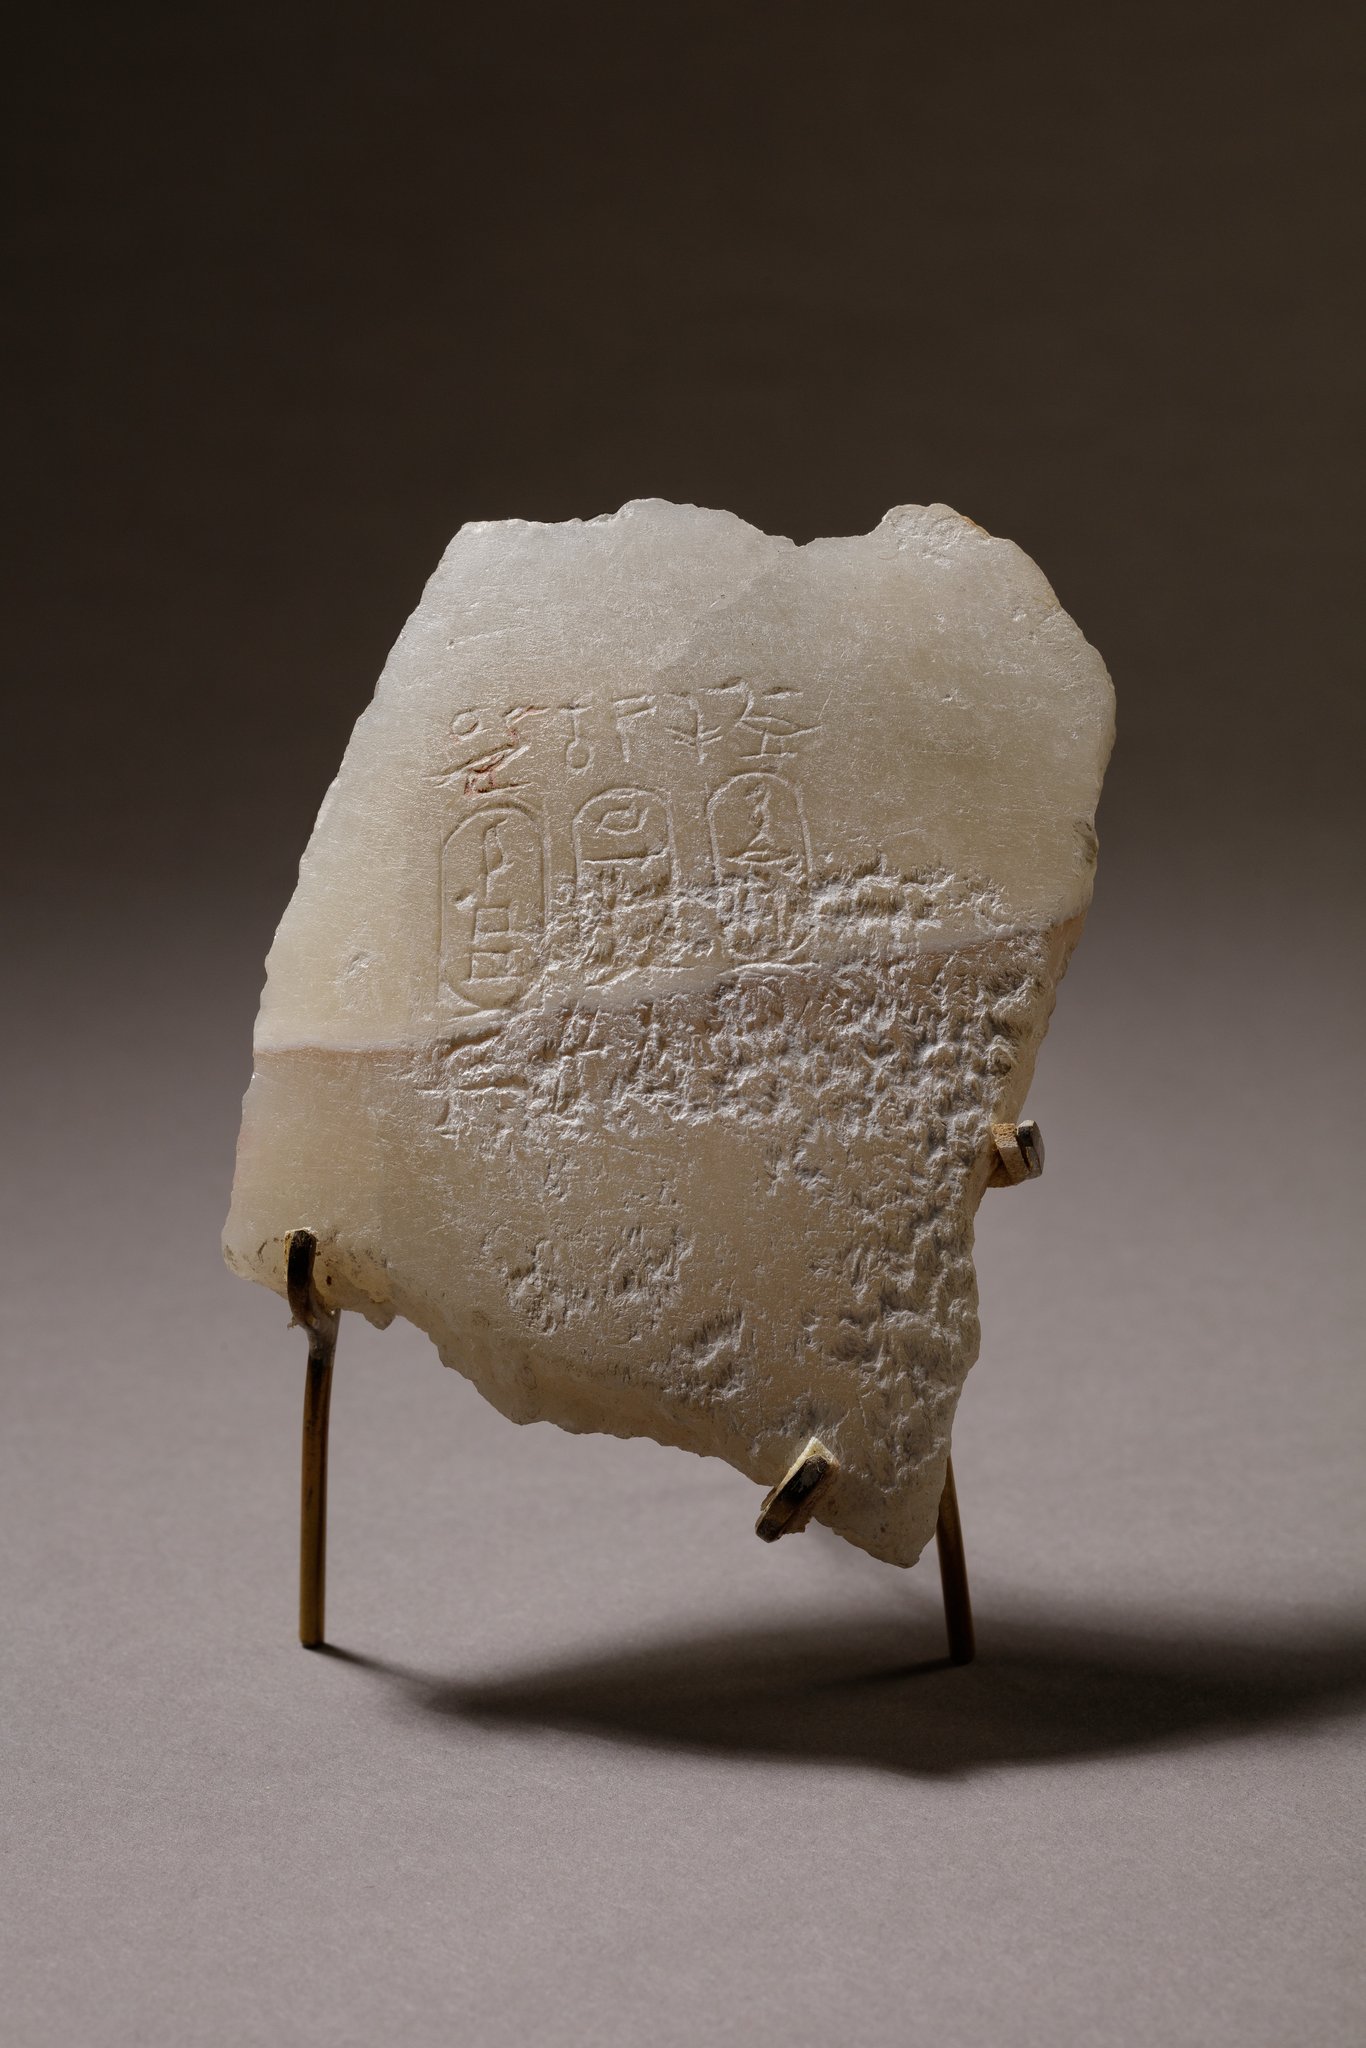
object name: jar fragment, apophis i, ahmose i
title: Jar fragment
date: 1525-1504 BCE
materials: stone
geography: egypt